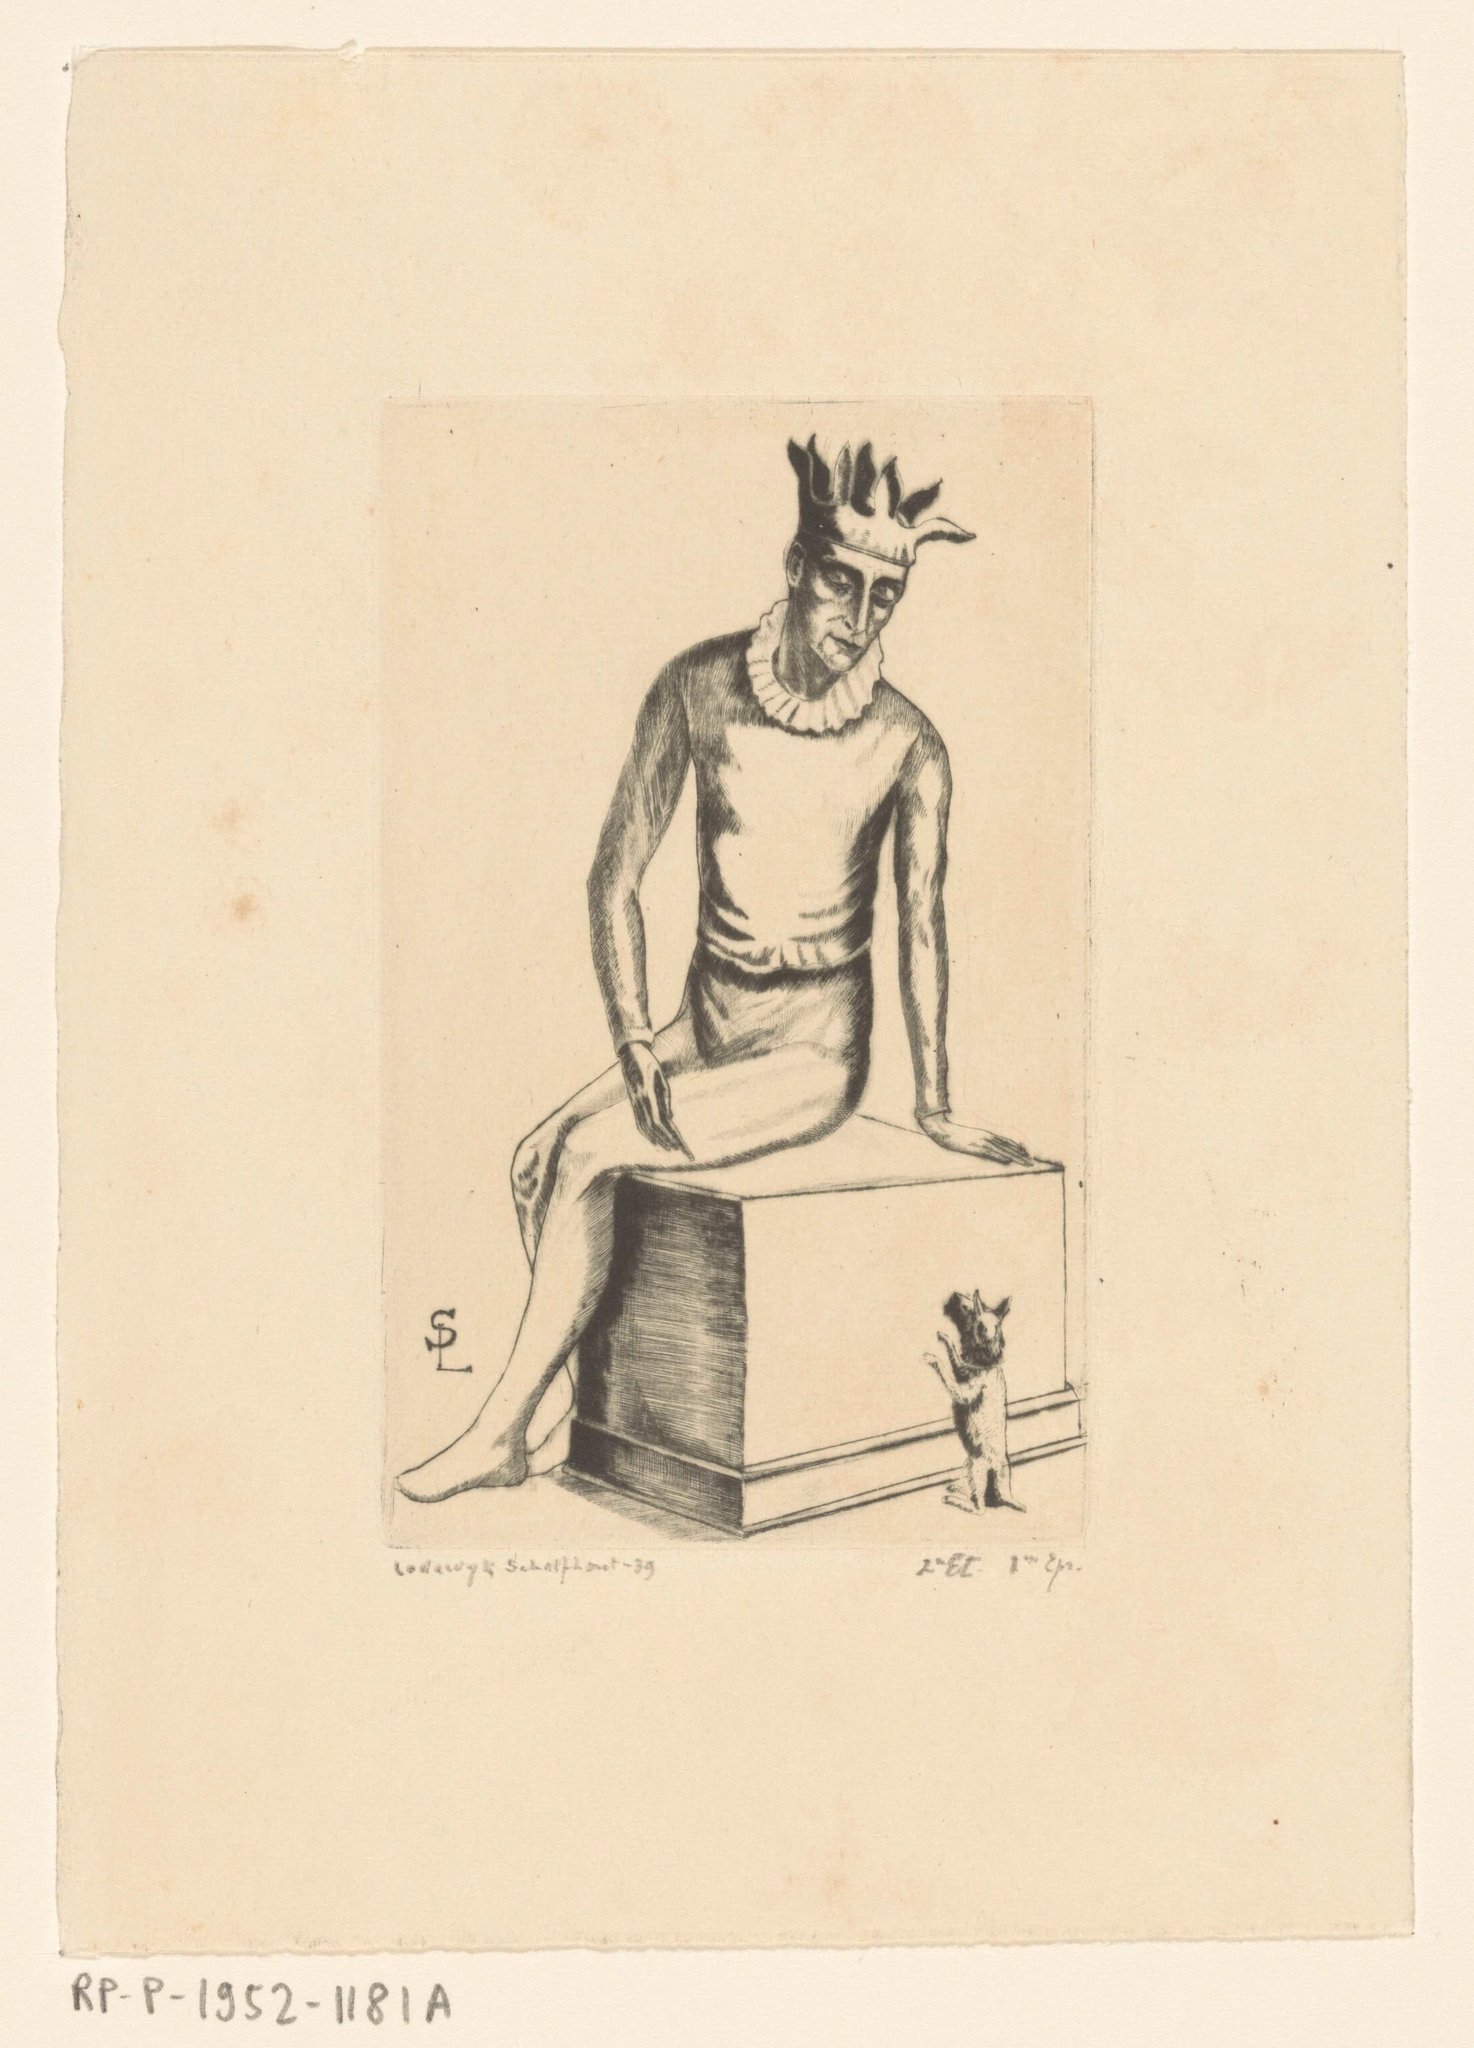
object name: print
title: L'Arlequin avec son chien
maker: lodewijk schelfhout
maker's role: draughtsman, print maker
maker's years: 1881-1943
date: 1939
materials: paper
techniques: drypoint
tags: types in 'commedia dell'arte': harlequin, dog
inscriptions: collector's mark: Lugt 2228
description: Een zittende harlekijn en een op zijn achterpoten staande hond kijken elkaar aan.